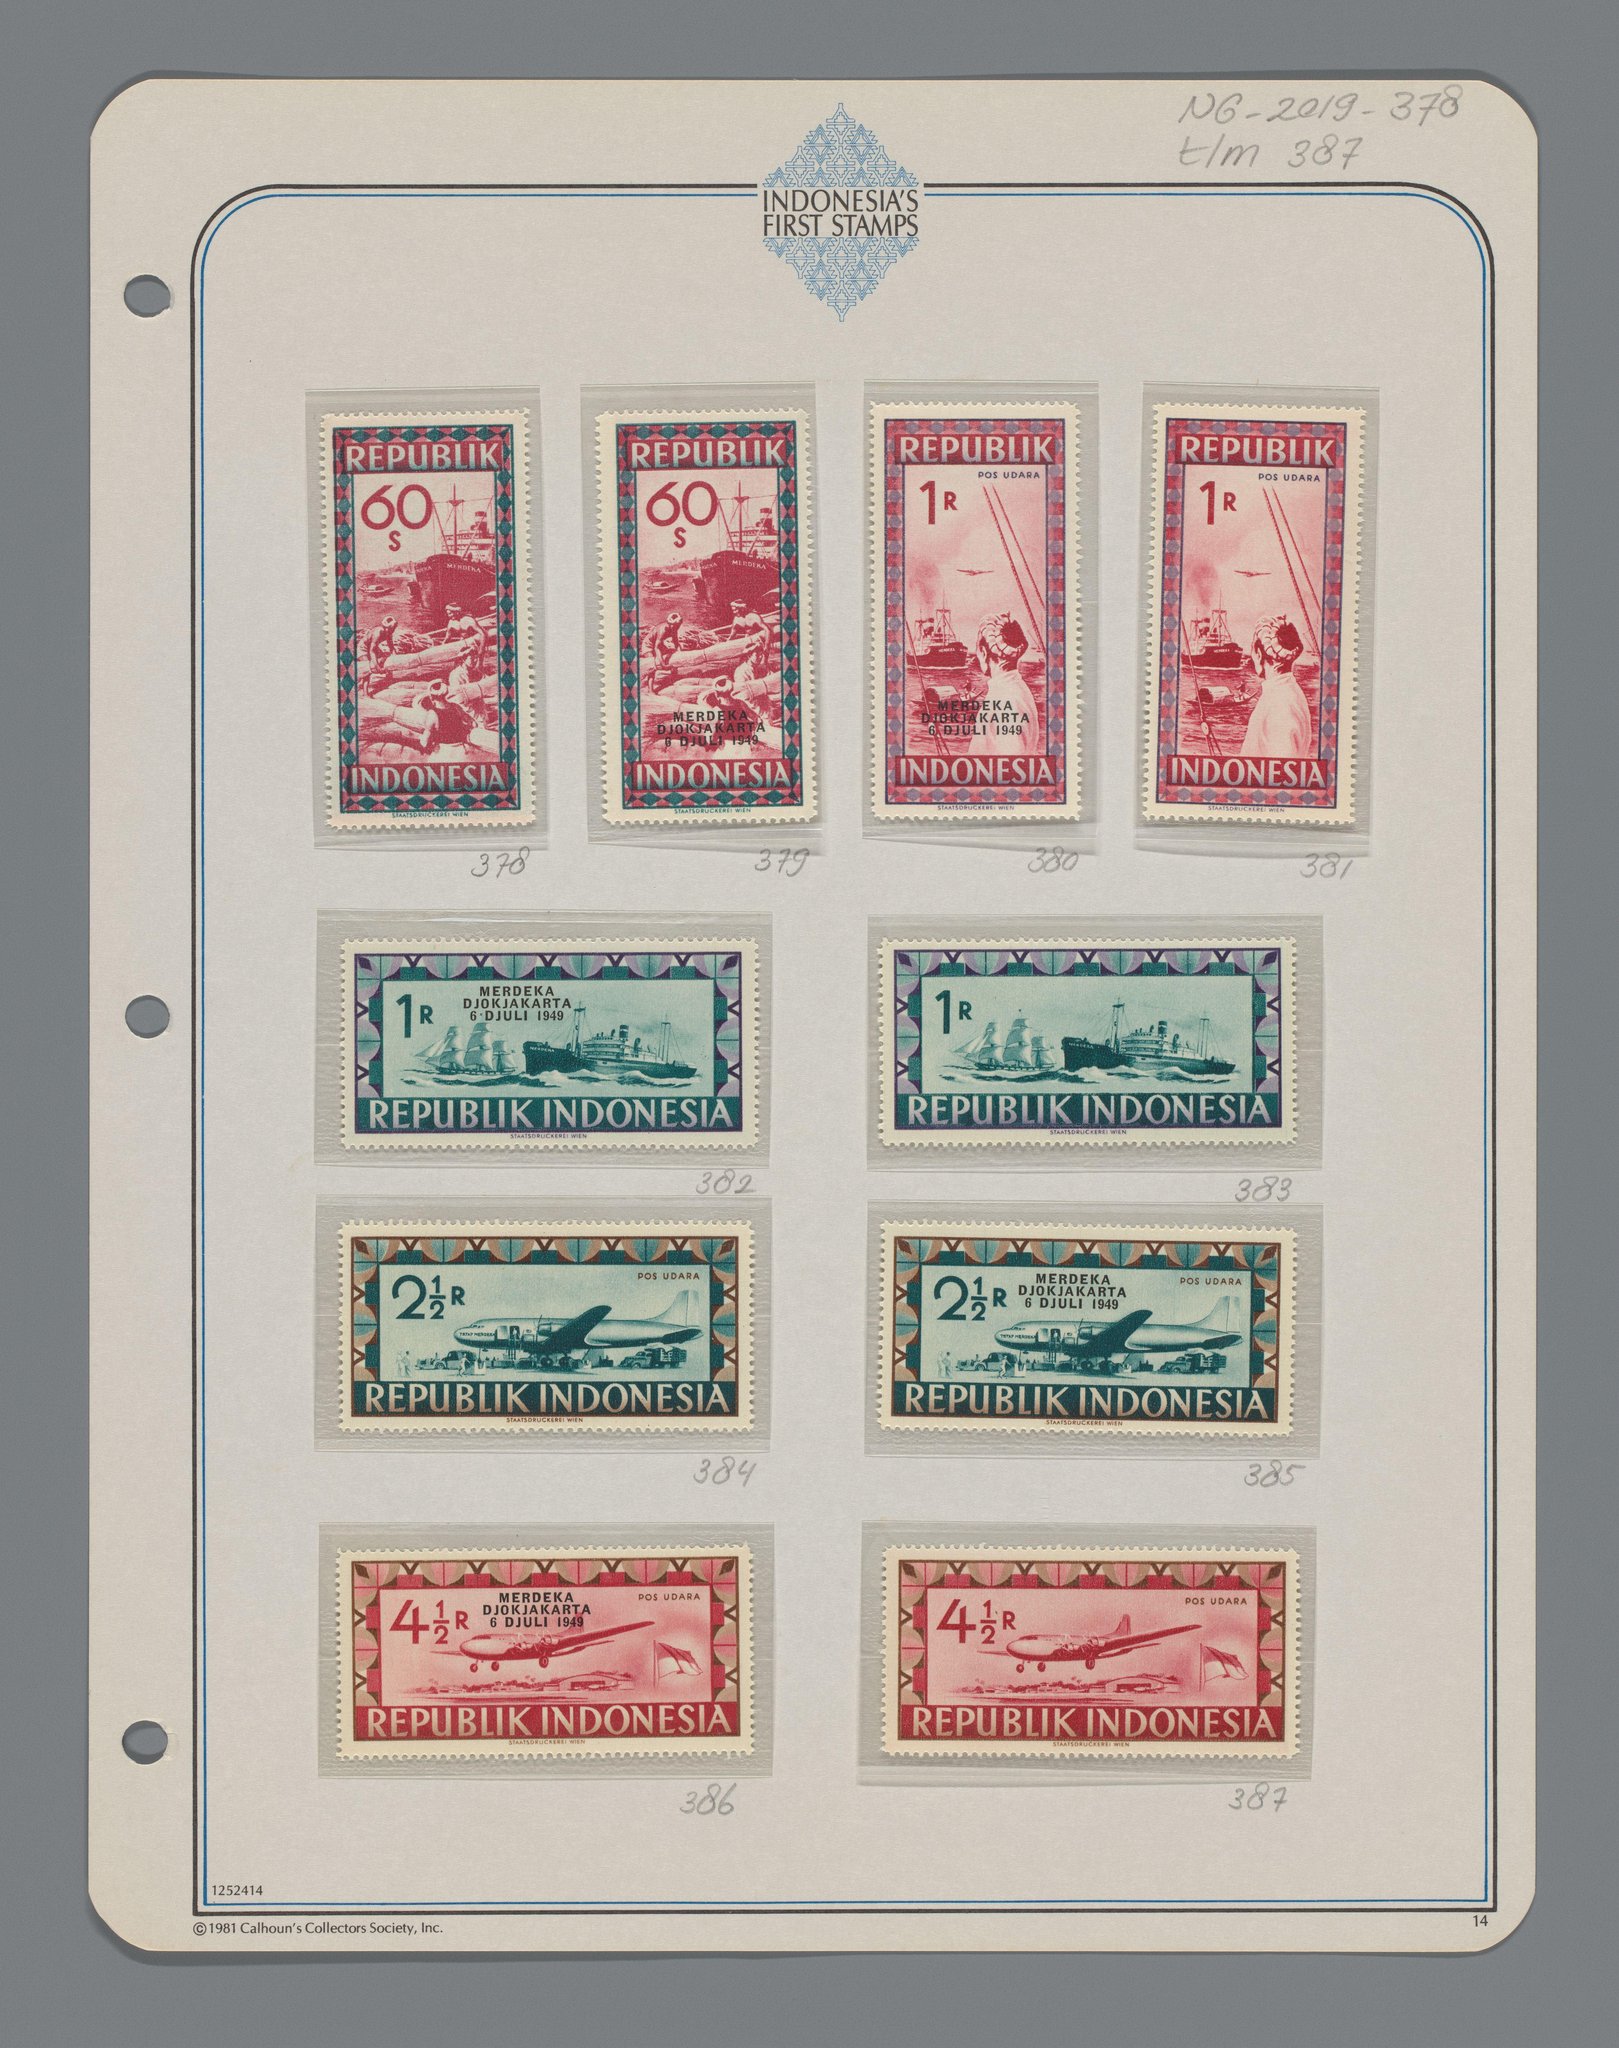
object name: postage stamp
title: Postzegel Republik Indonesia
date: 1949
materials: paper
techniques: photoaquatint, engraving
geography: vienna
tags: indonesia